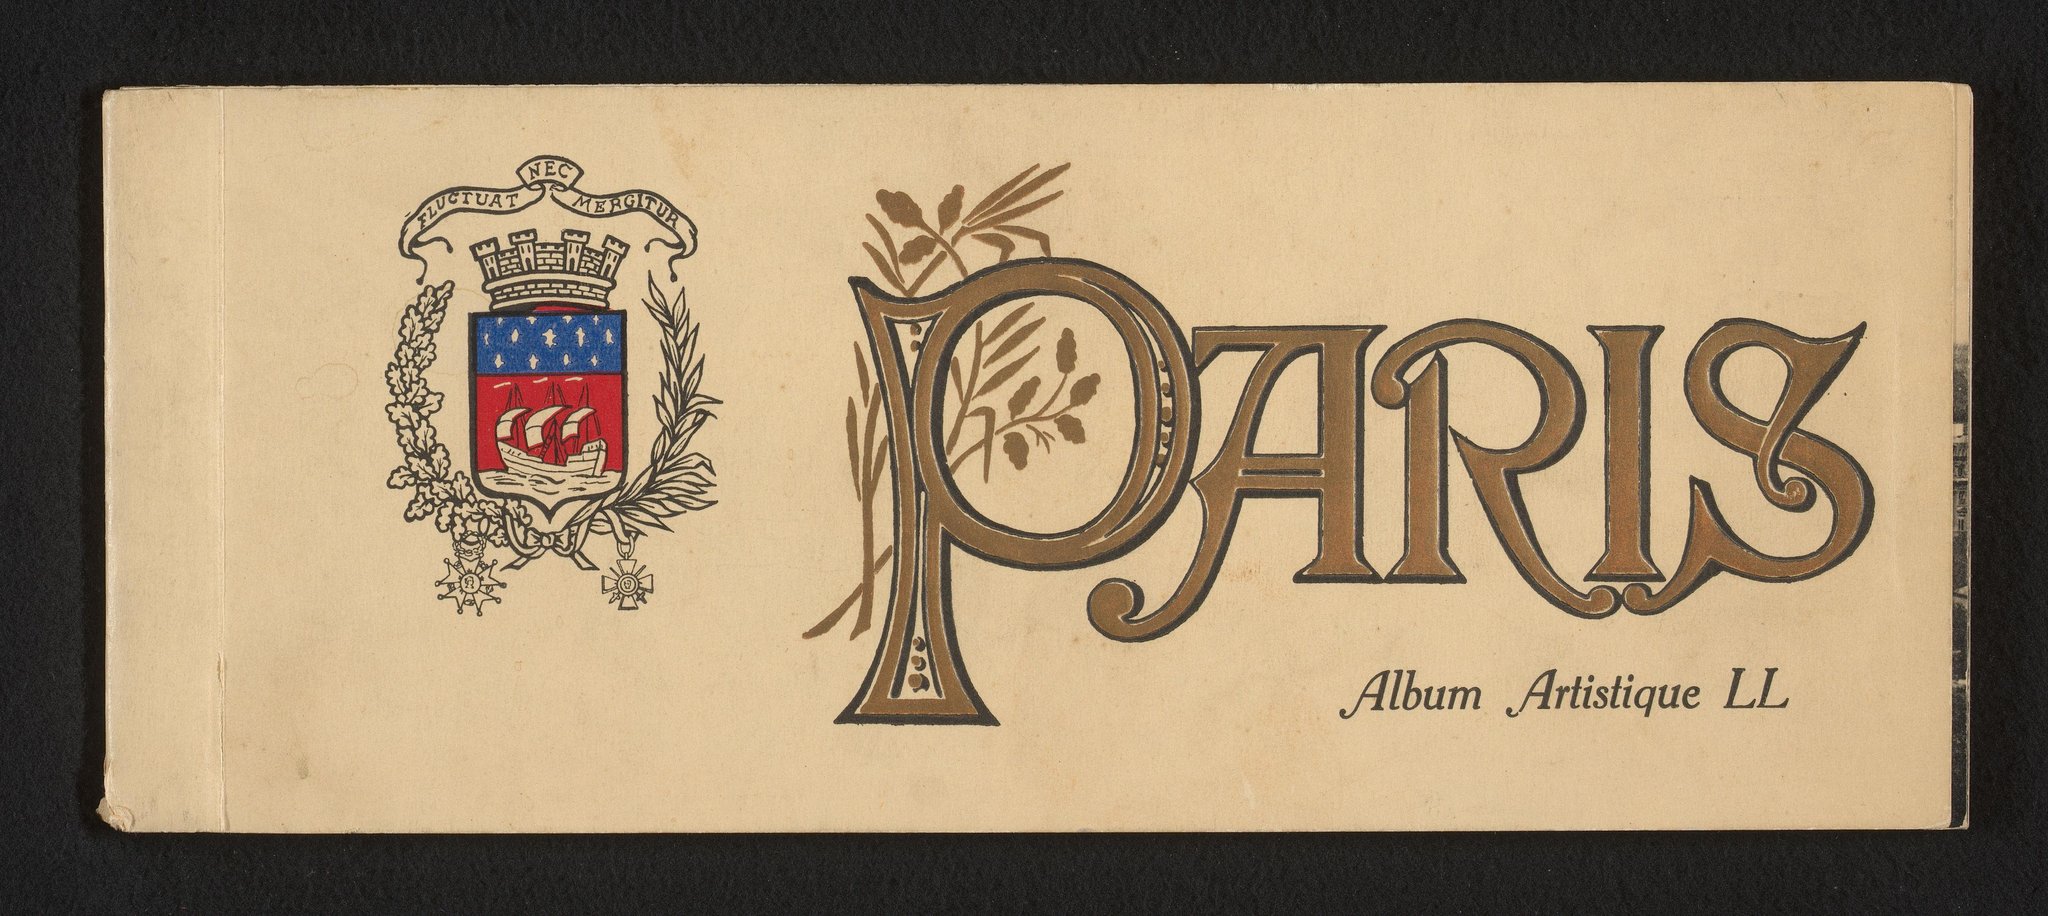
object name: album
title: Album met voorstellingen van Parijs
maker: Anonymous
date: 1920-1932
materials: cardboard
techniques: blind stamped, photograph, letterpress printing, printing block, stapling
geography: paris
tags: coat of arms (symbol of sovereignty), city-view, and landscape with man-made constructions (+ city(-scape) with figures, staffage), paris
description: Album met 24 voorstellingen van Parijs. De voorstellingen zijn op de rechterzijde van de pagina's, de linkerzijden zijn leeg. De aaneengeniete voorstellingen zijn inmiddels los van het omslag geraakt.